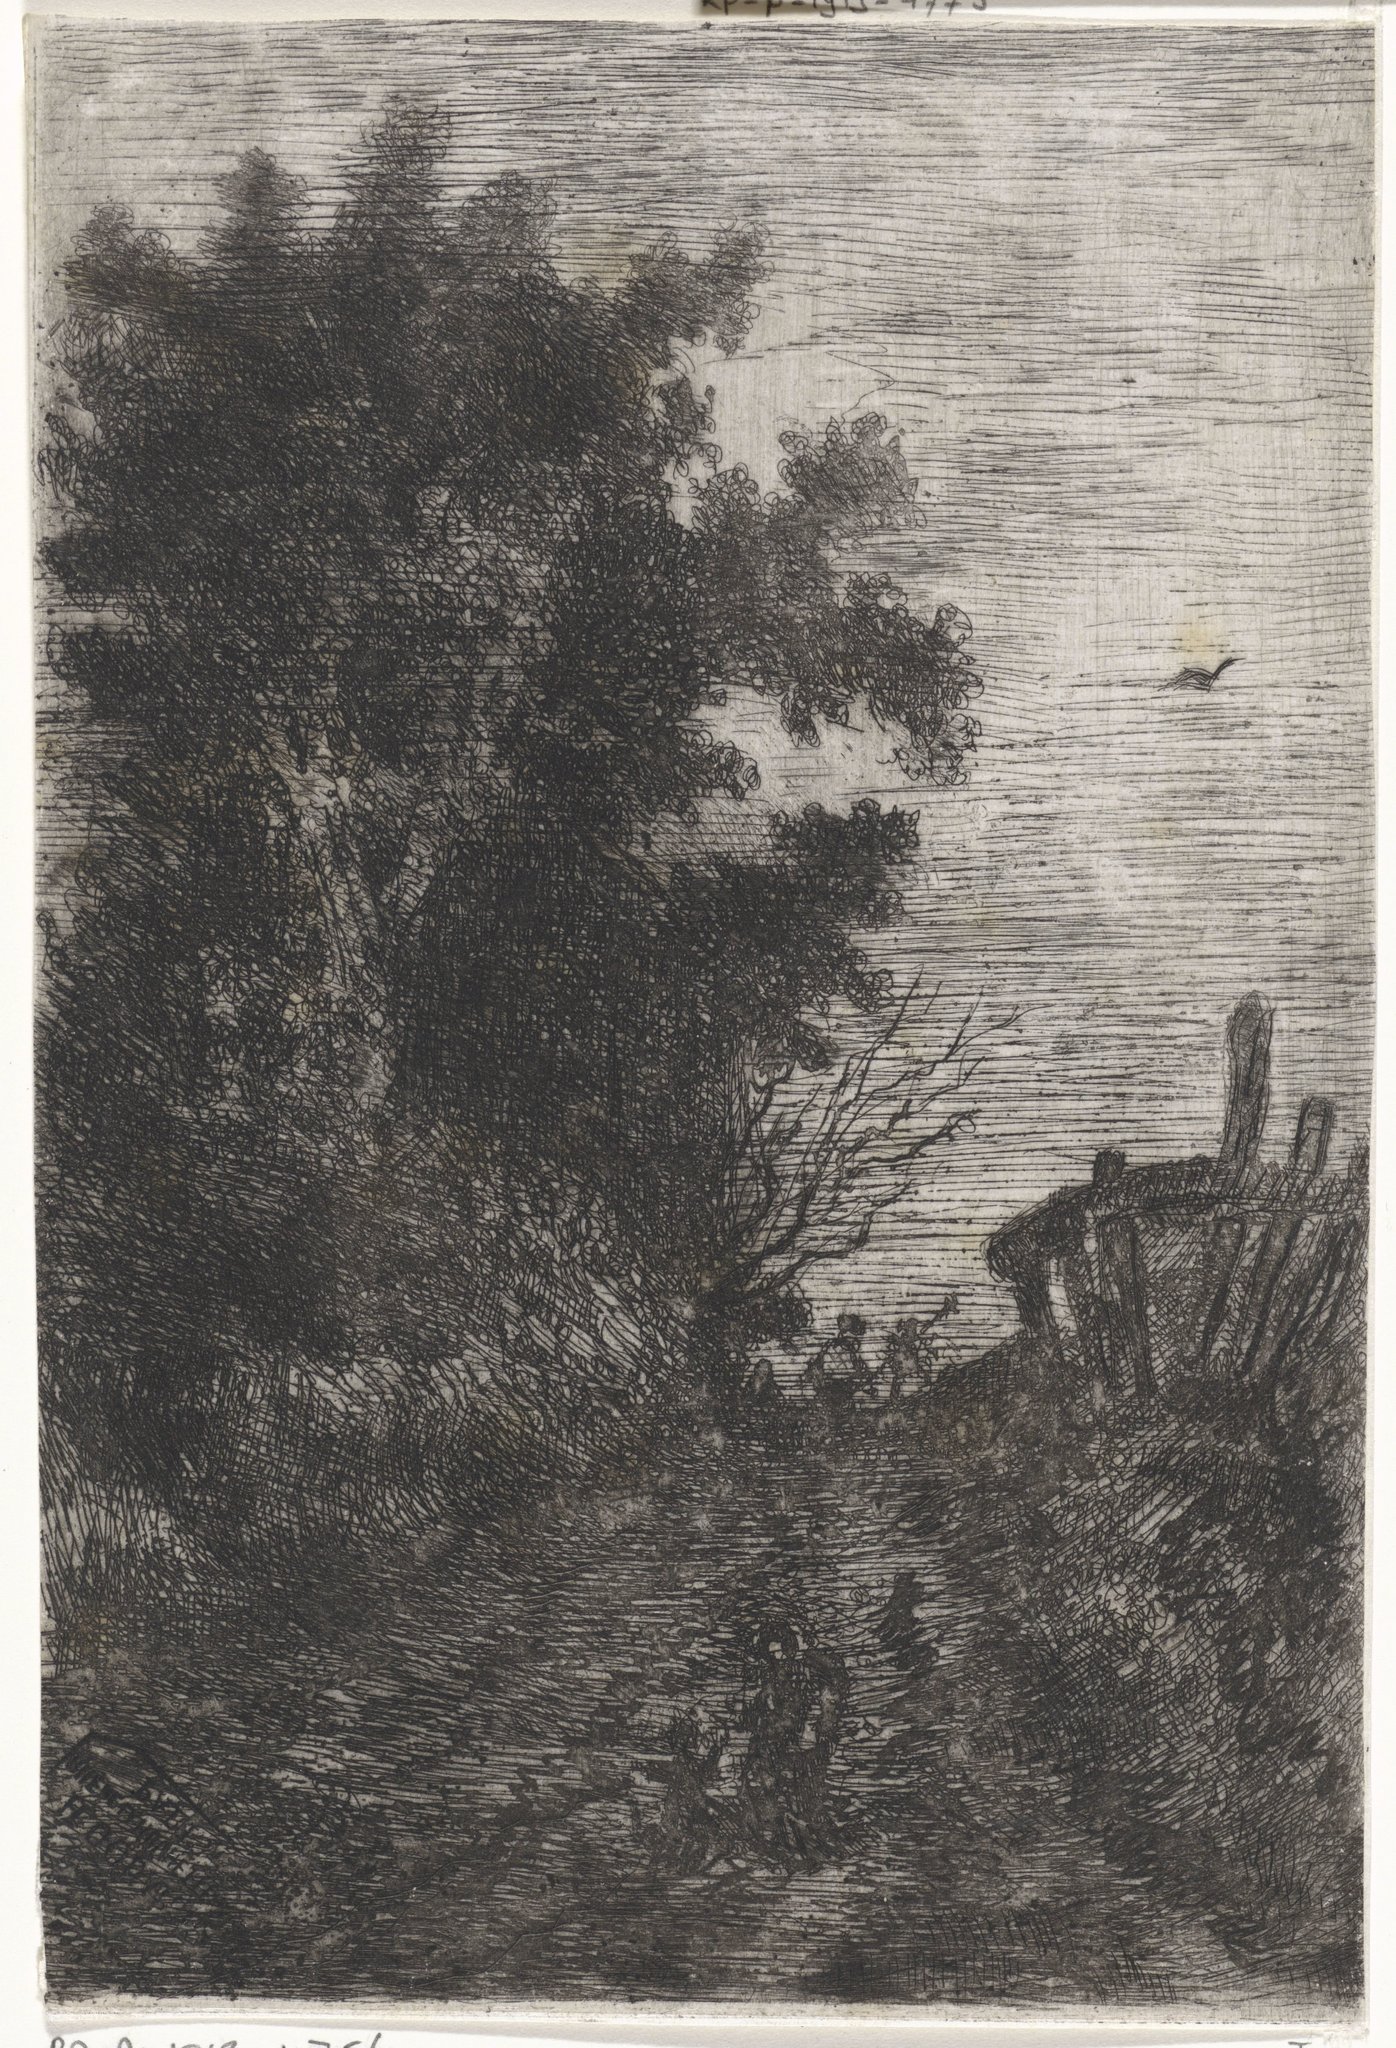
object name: print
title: Wandelaar op een pad langs de bosrand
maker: arnoud schaepkens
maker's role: print maker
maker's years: 1816-1904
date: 1831-1904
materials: paper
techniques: drypoint, etching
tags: fence, wall, paling, forest path or lane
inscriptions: collector's mark: Lugt 2228